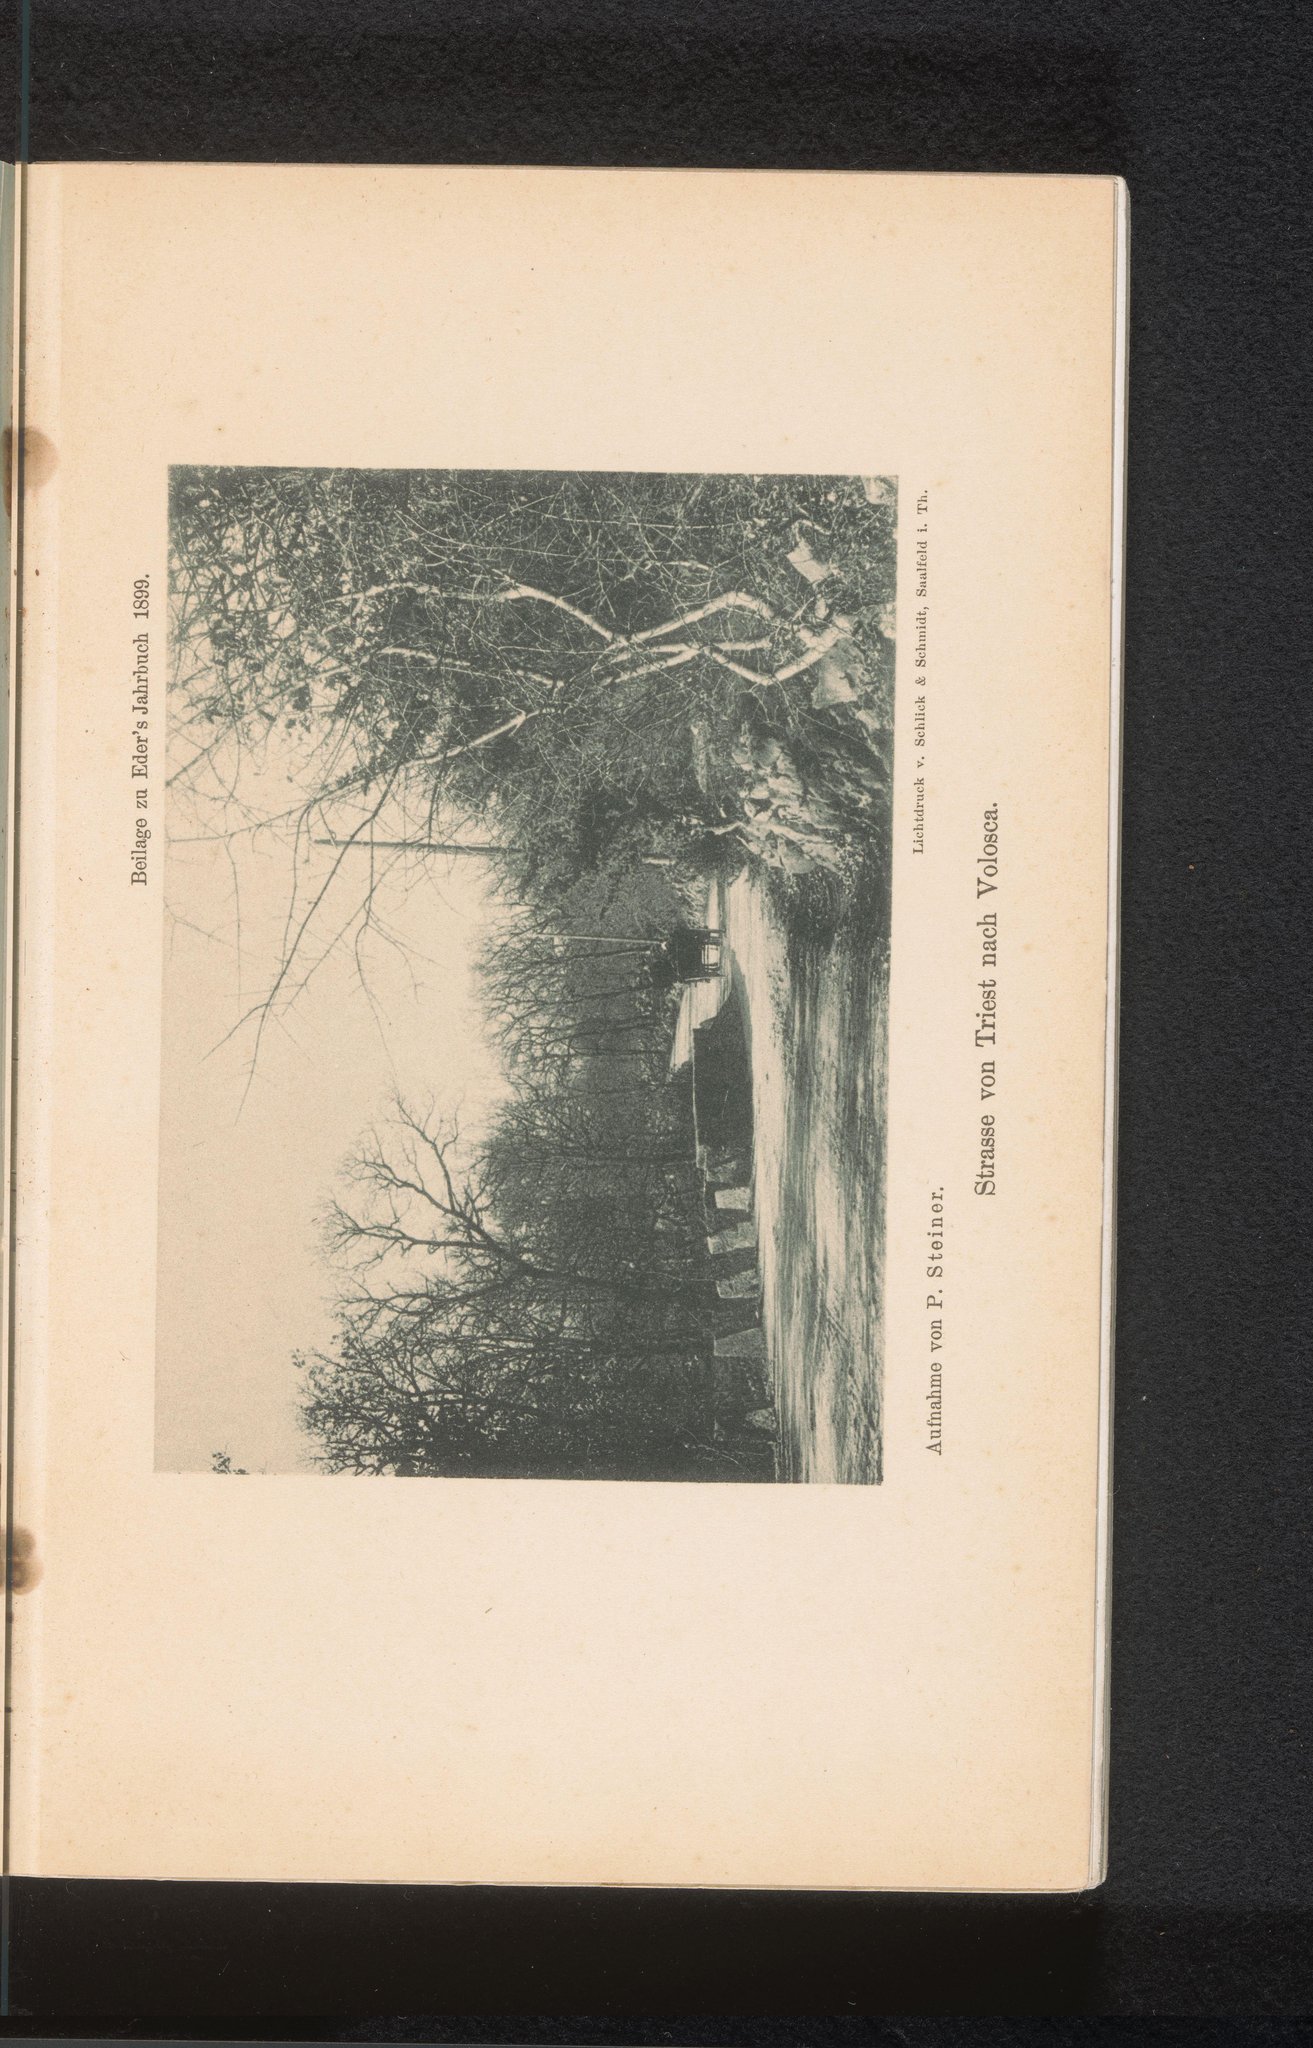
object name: photomechanical print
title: Gezicht op een door paarden getrokken kar op een pad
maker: p. steiner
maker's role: fotograaf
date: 1894-1899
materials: paper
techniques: photograph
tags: animal traction, animal-drawn vehicle (carriage etc.), trees, road, path